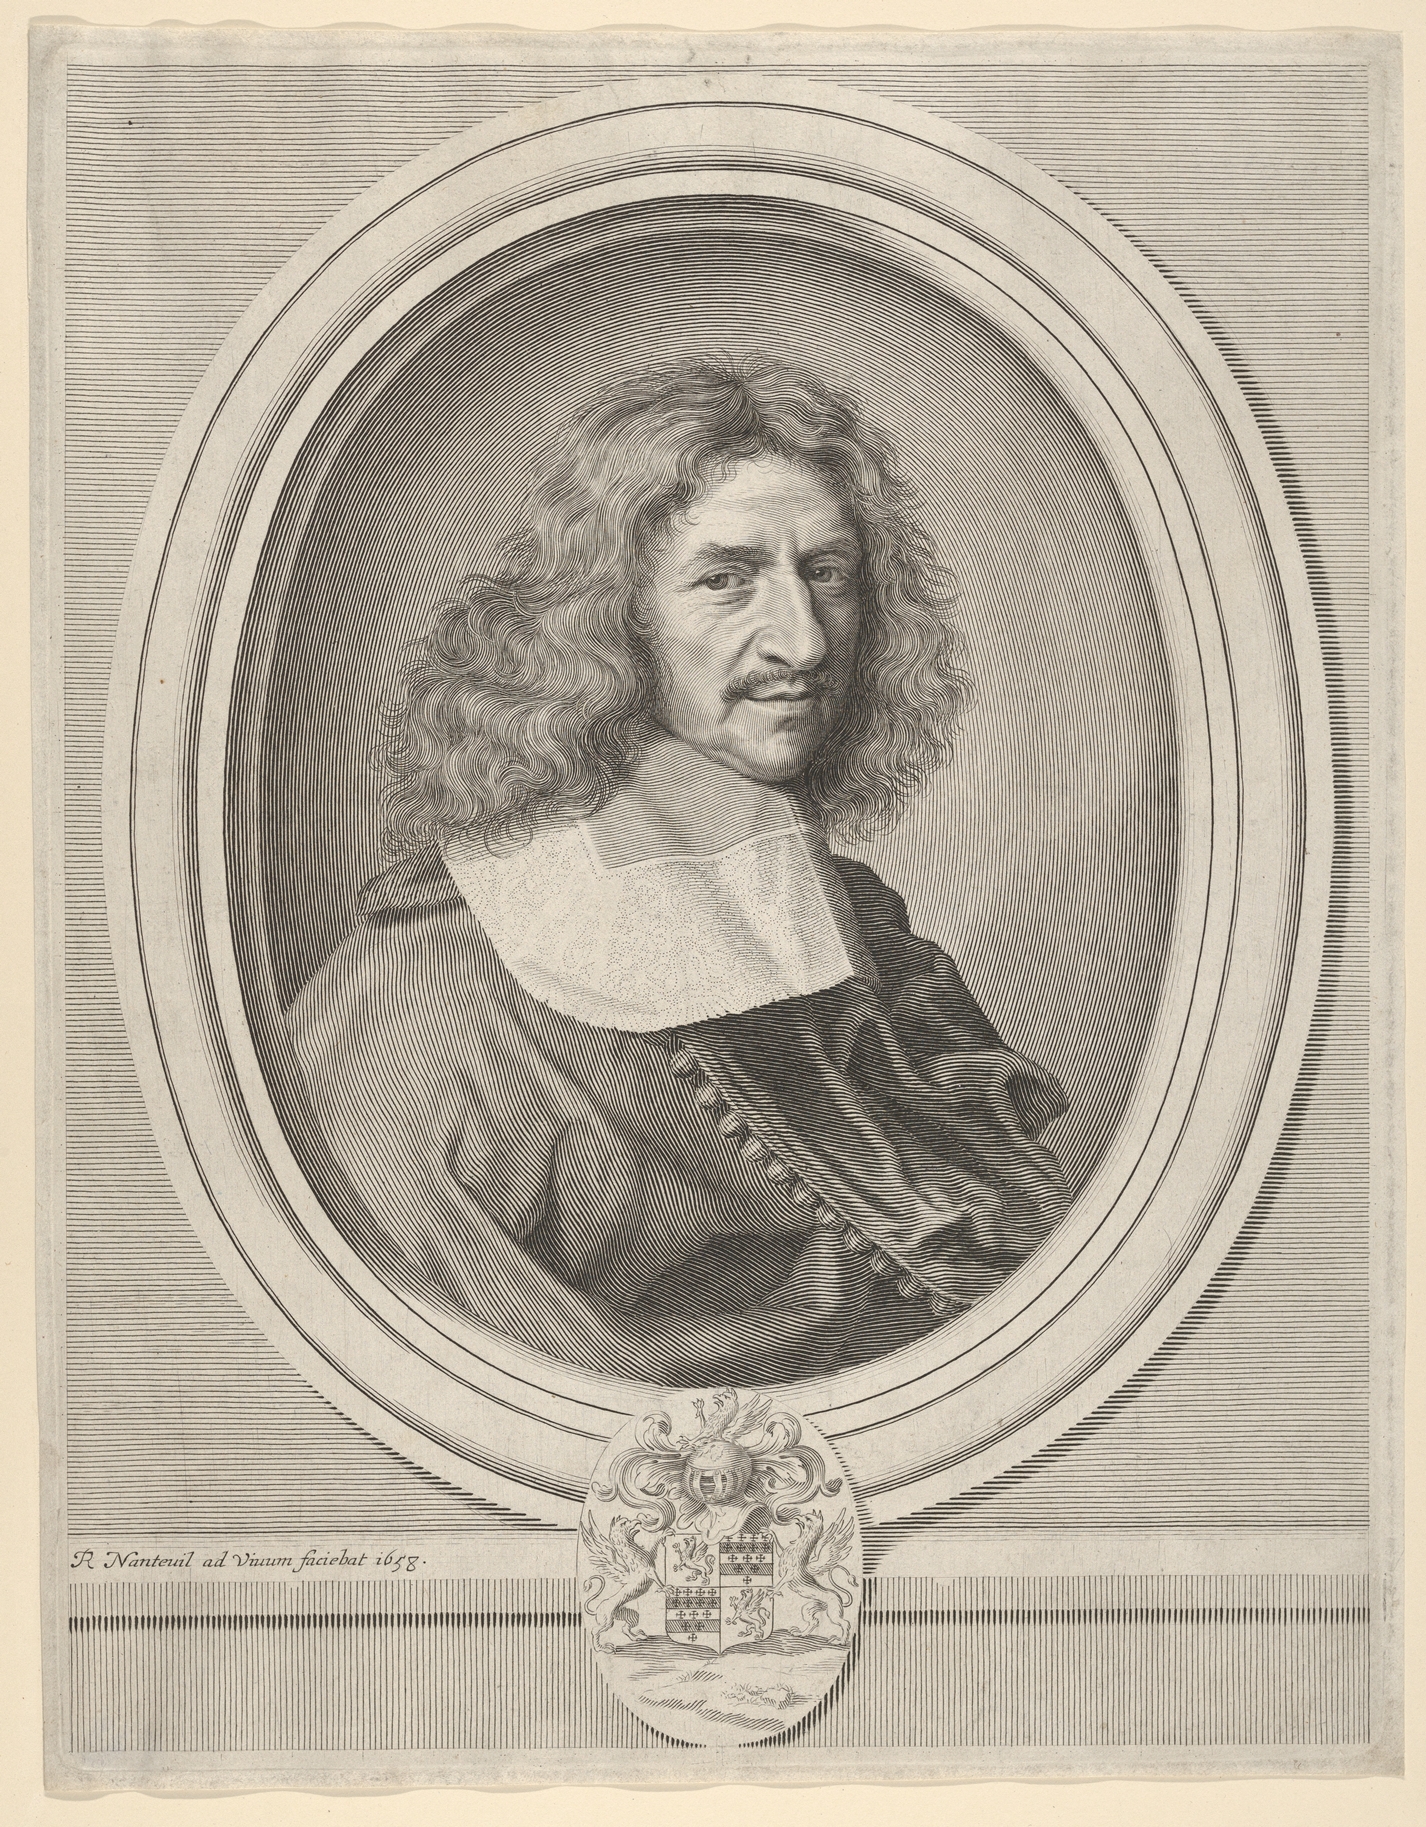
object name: print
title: Louis Hesselin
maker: robert nanteuil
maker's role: artist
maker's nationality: french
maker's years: 1623-1678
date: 1658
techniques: engraving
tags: men,portraits,coat of arms